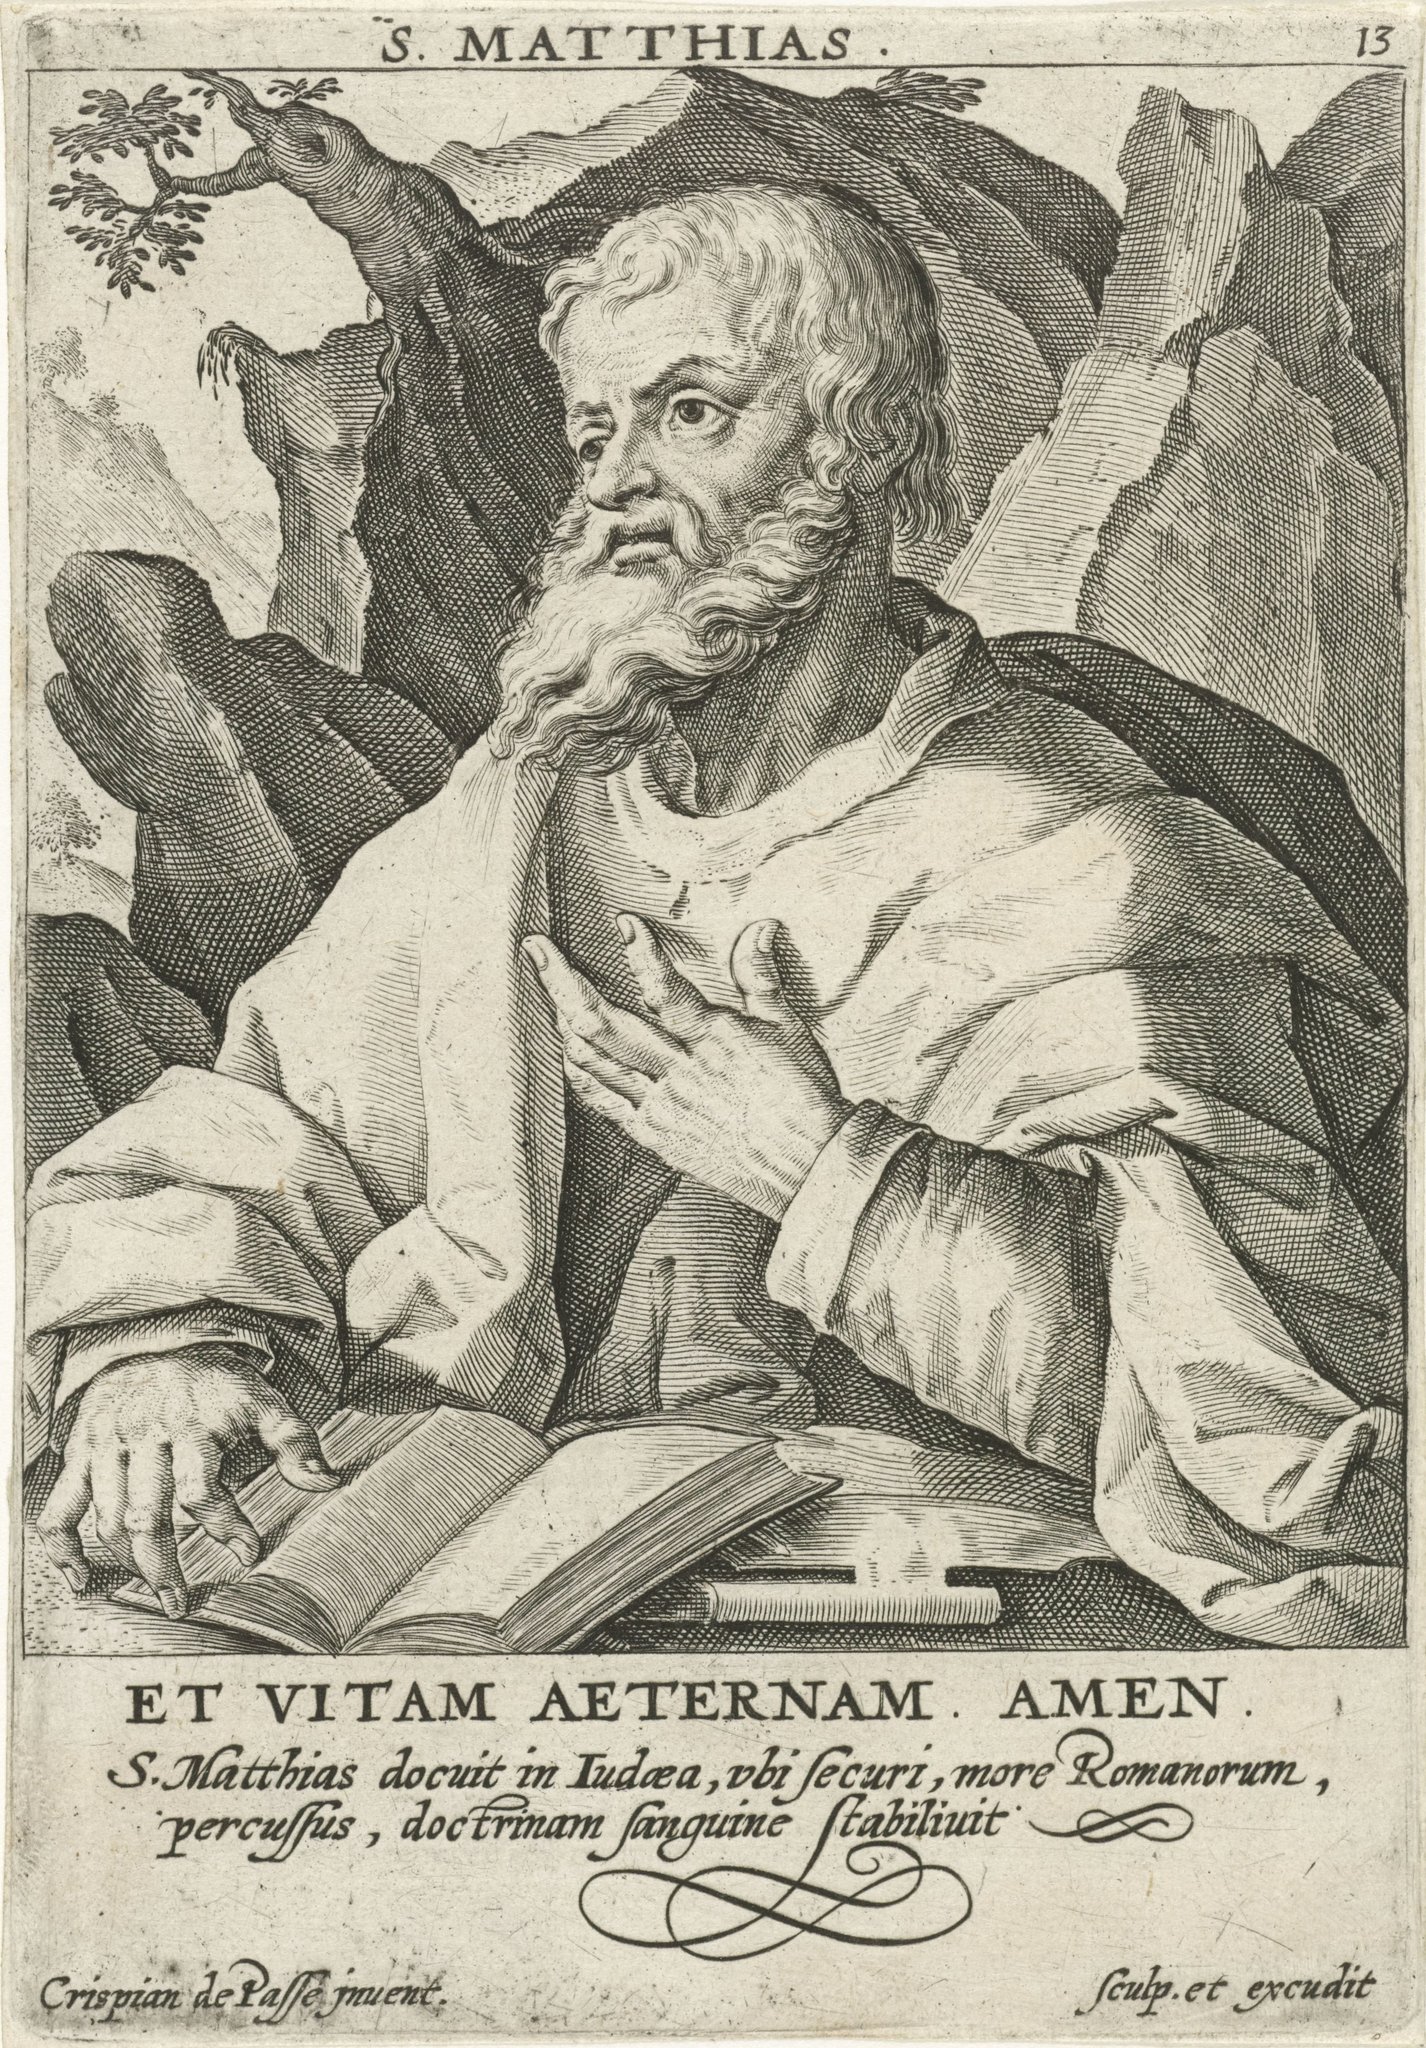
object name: print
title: S. Matthias.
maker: crispijn van de passe (i)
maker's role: draughtsman, print maker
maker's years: 1564-1637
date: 1594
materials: paper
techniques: engraving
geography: cologne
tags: the apostle and martyr matthias; possible attributes: axe, book, cross, halberd, scroll, sword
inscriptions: collector's mark: Lugt 2542, collector's mark: Lugt 2228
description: Buste van de apostel Mattias, een opengeslagen boek en een hellebaard voor hem. Hij houdt zijn linkerhand tegen zijn borst aan. In de marge een onderschrift in het Latijn. Prent uit een serie met Christus en de apostelen.